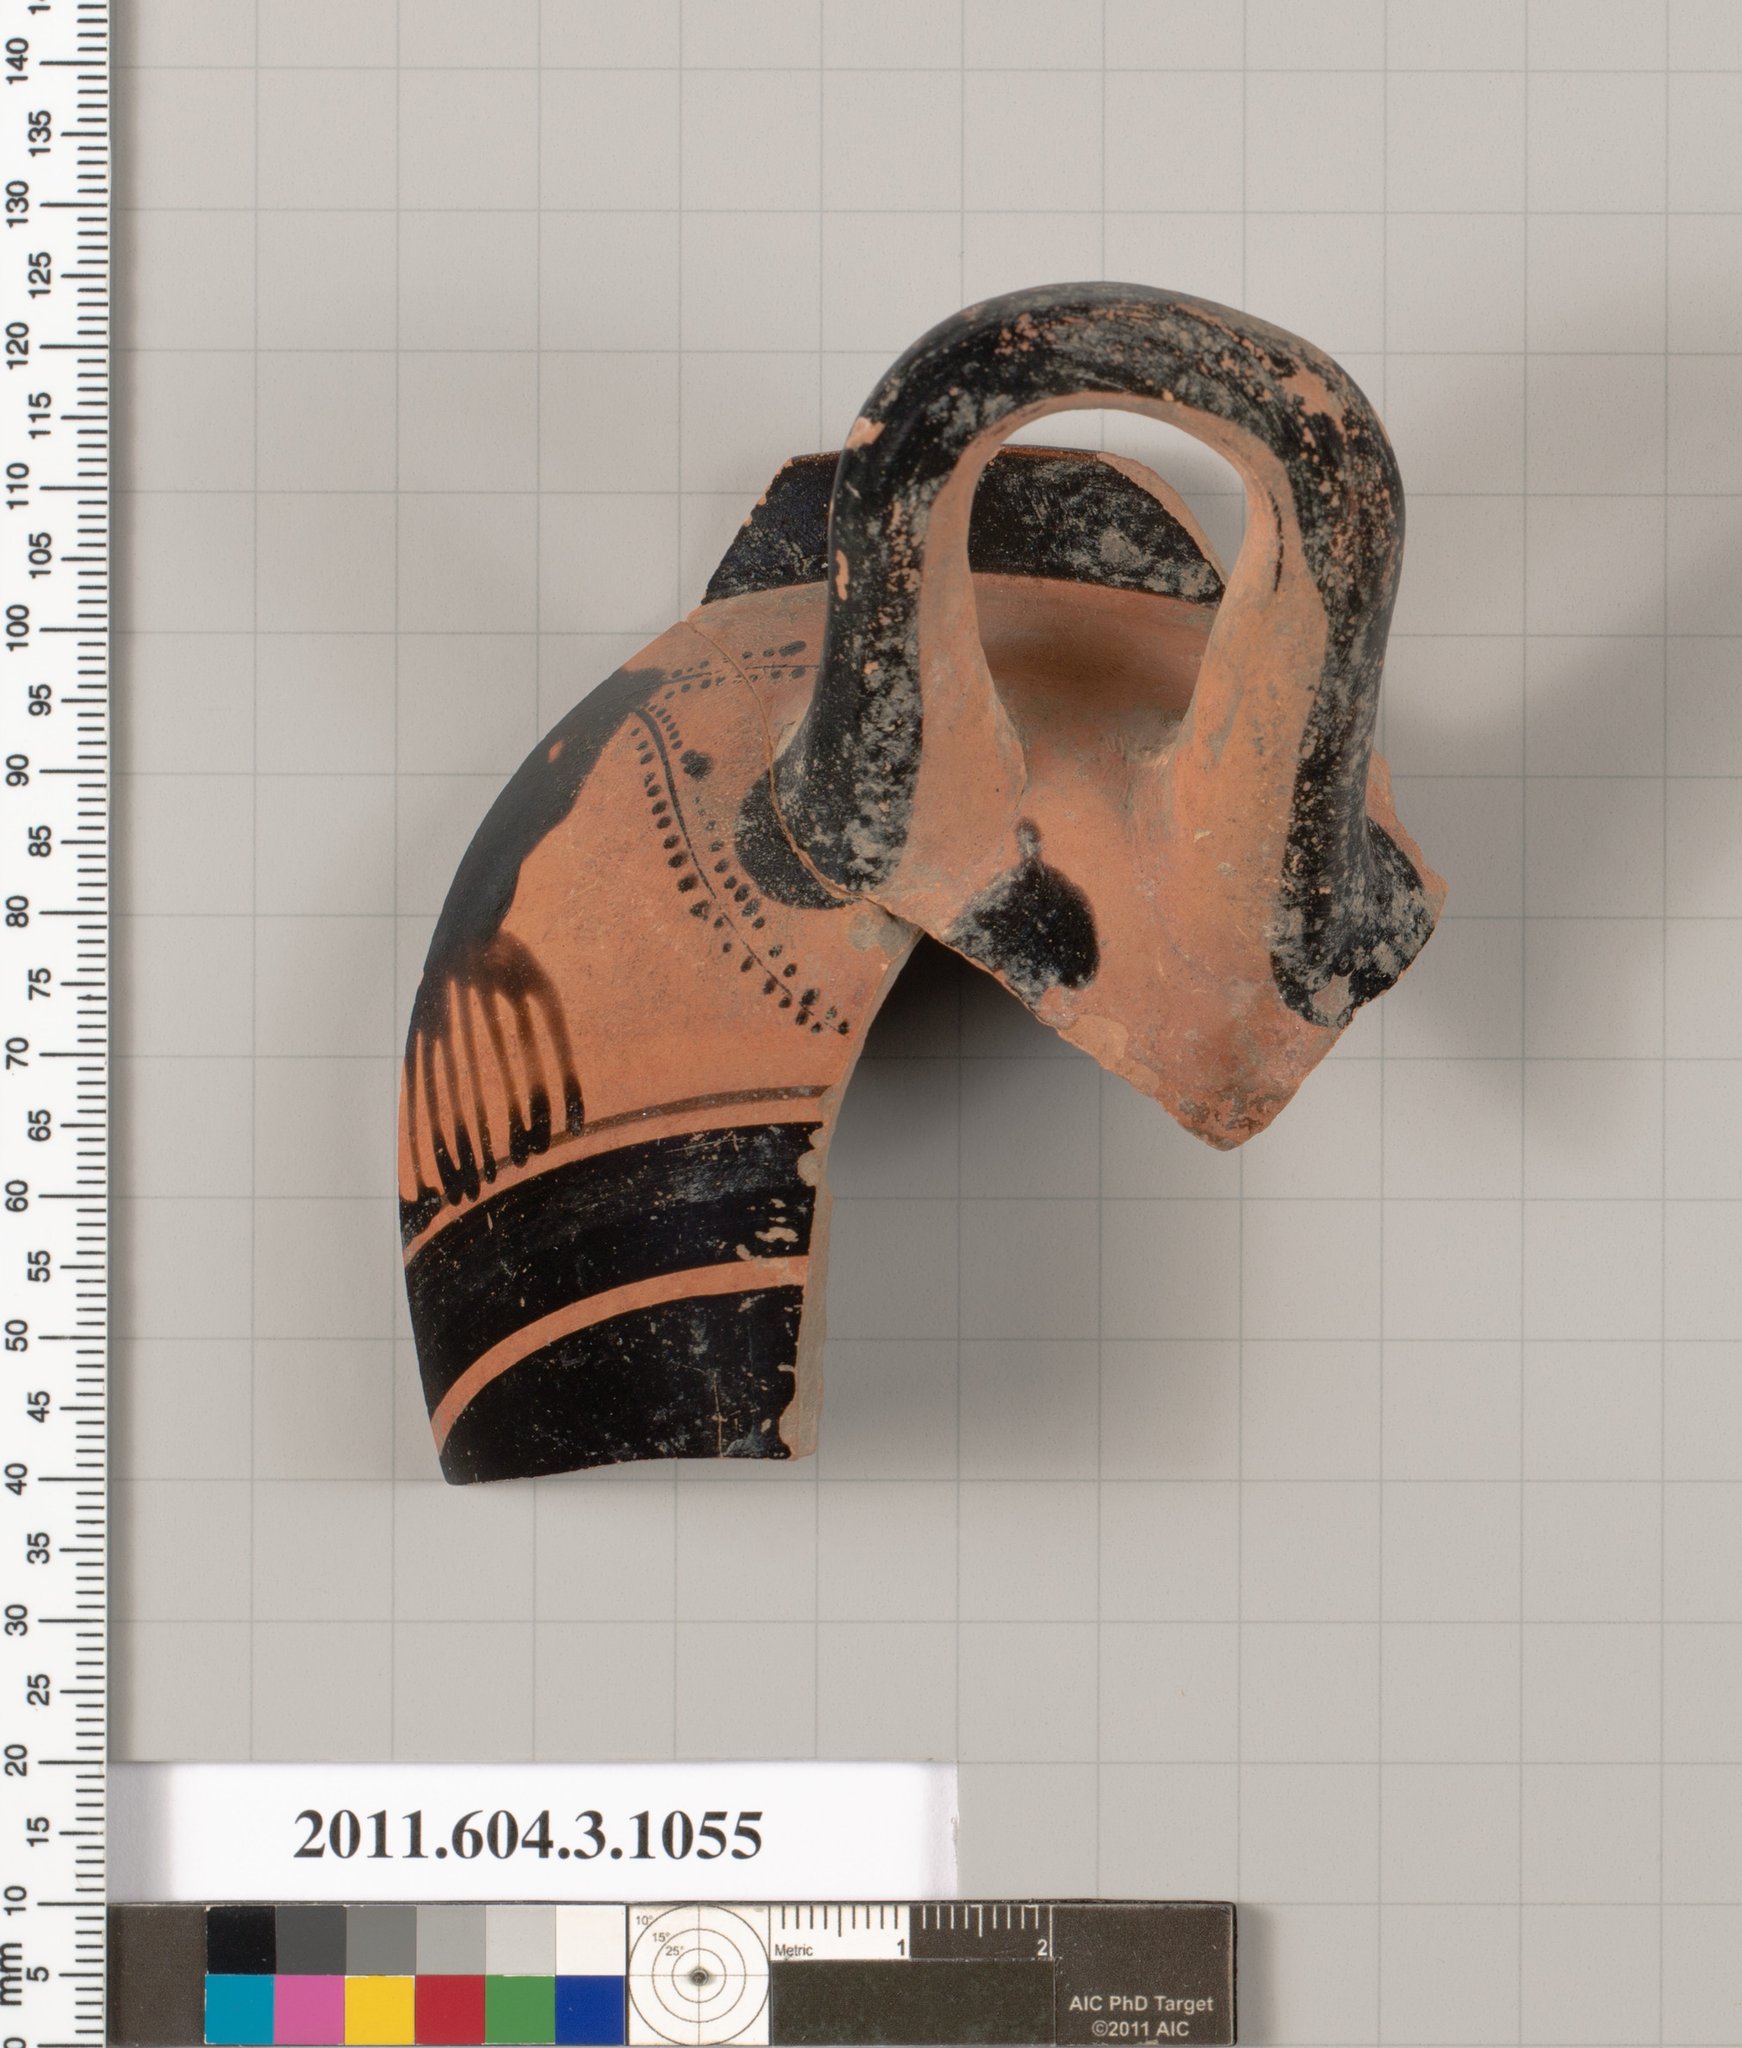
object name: mastoid fragment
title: Terracotta fragment of a mastoid (drinking cup with narrow base)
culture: greek, attic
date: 534-468 BCE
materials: terracotta